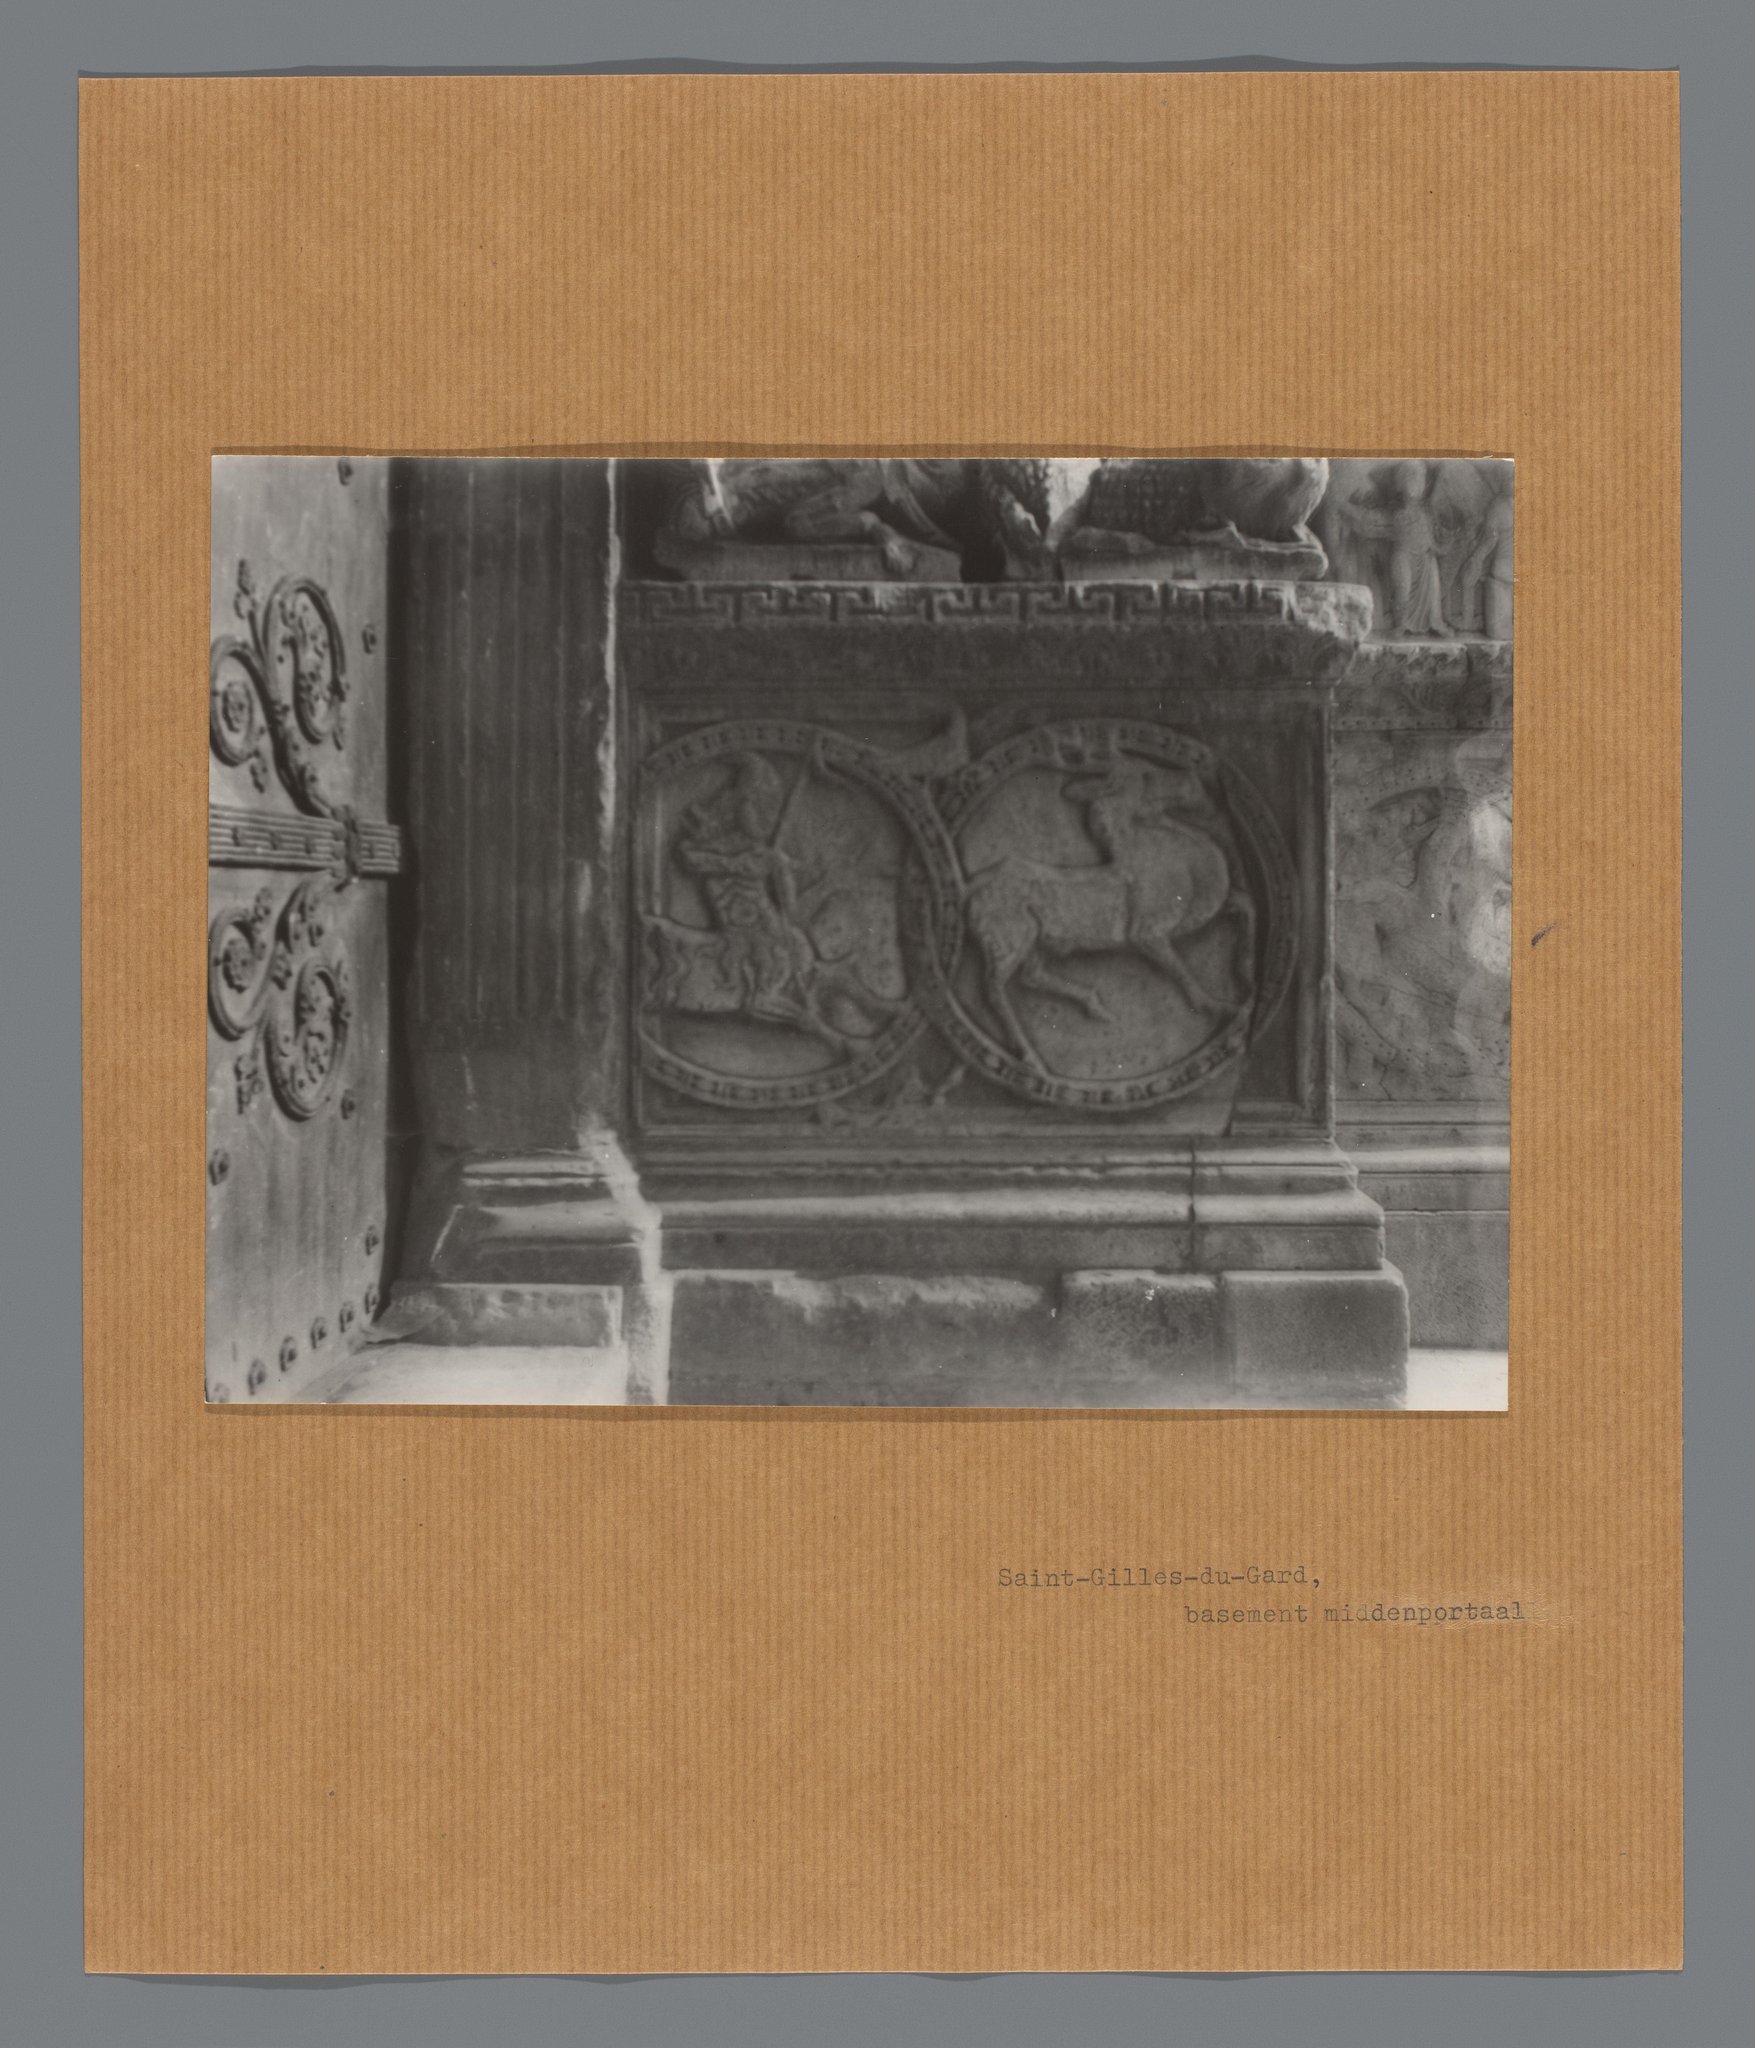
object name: photograph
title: Saint-Gilles, Kirche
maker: Anonymous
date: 1880-1930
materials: photographic support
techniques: gelatin silver print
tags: france